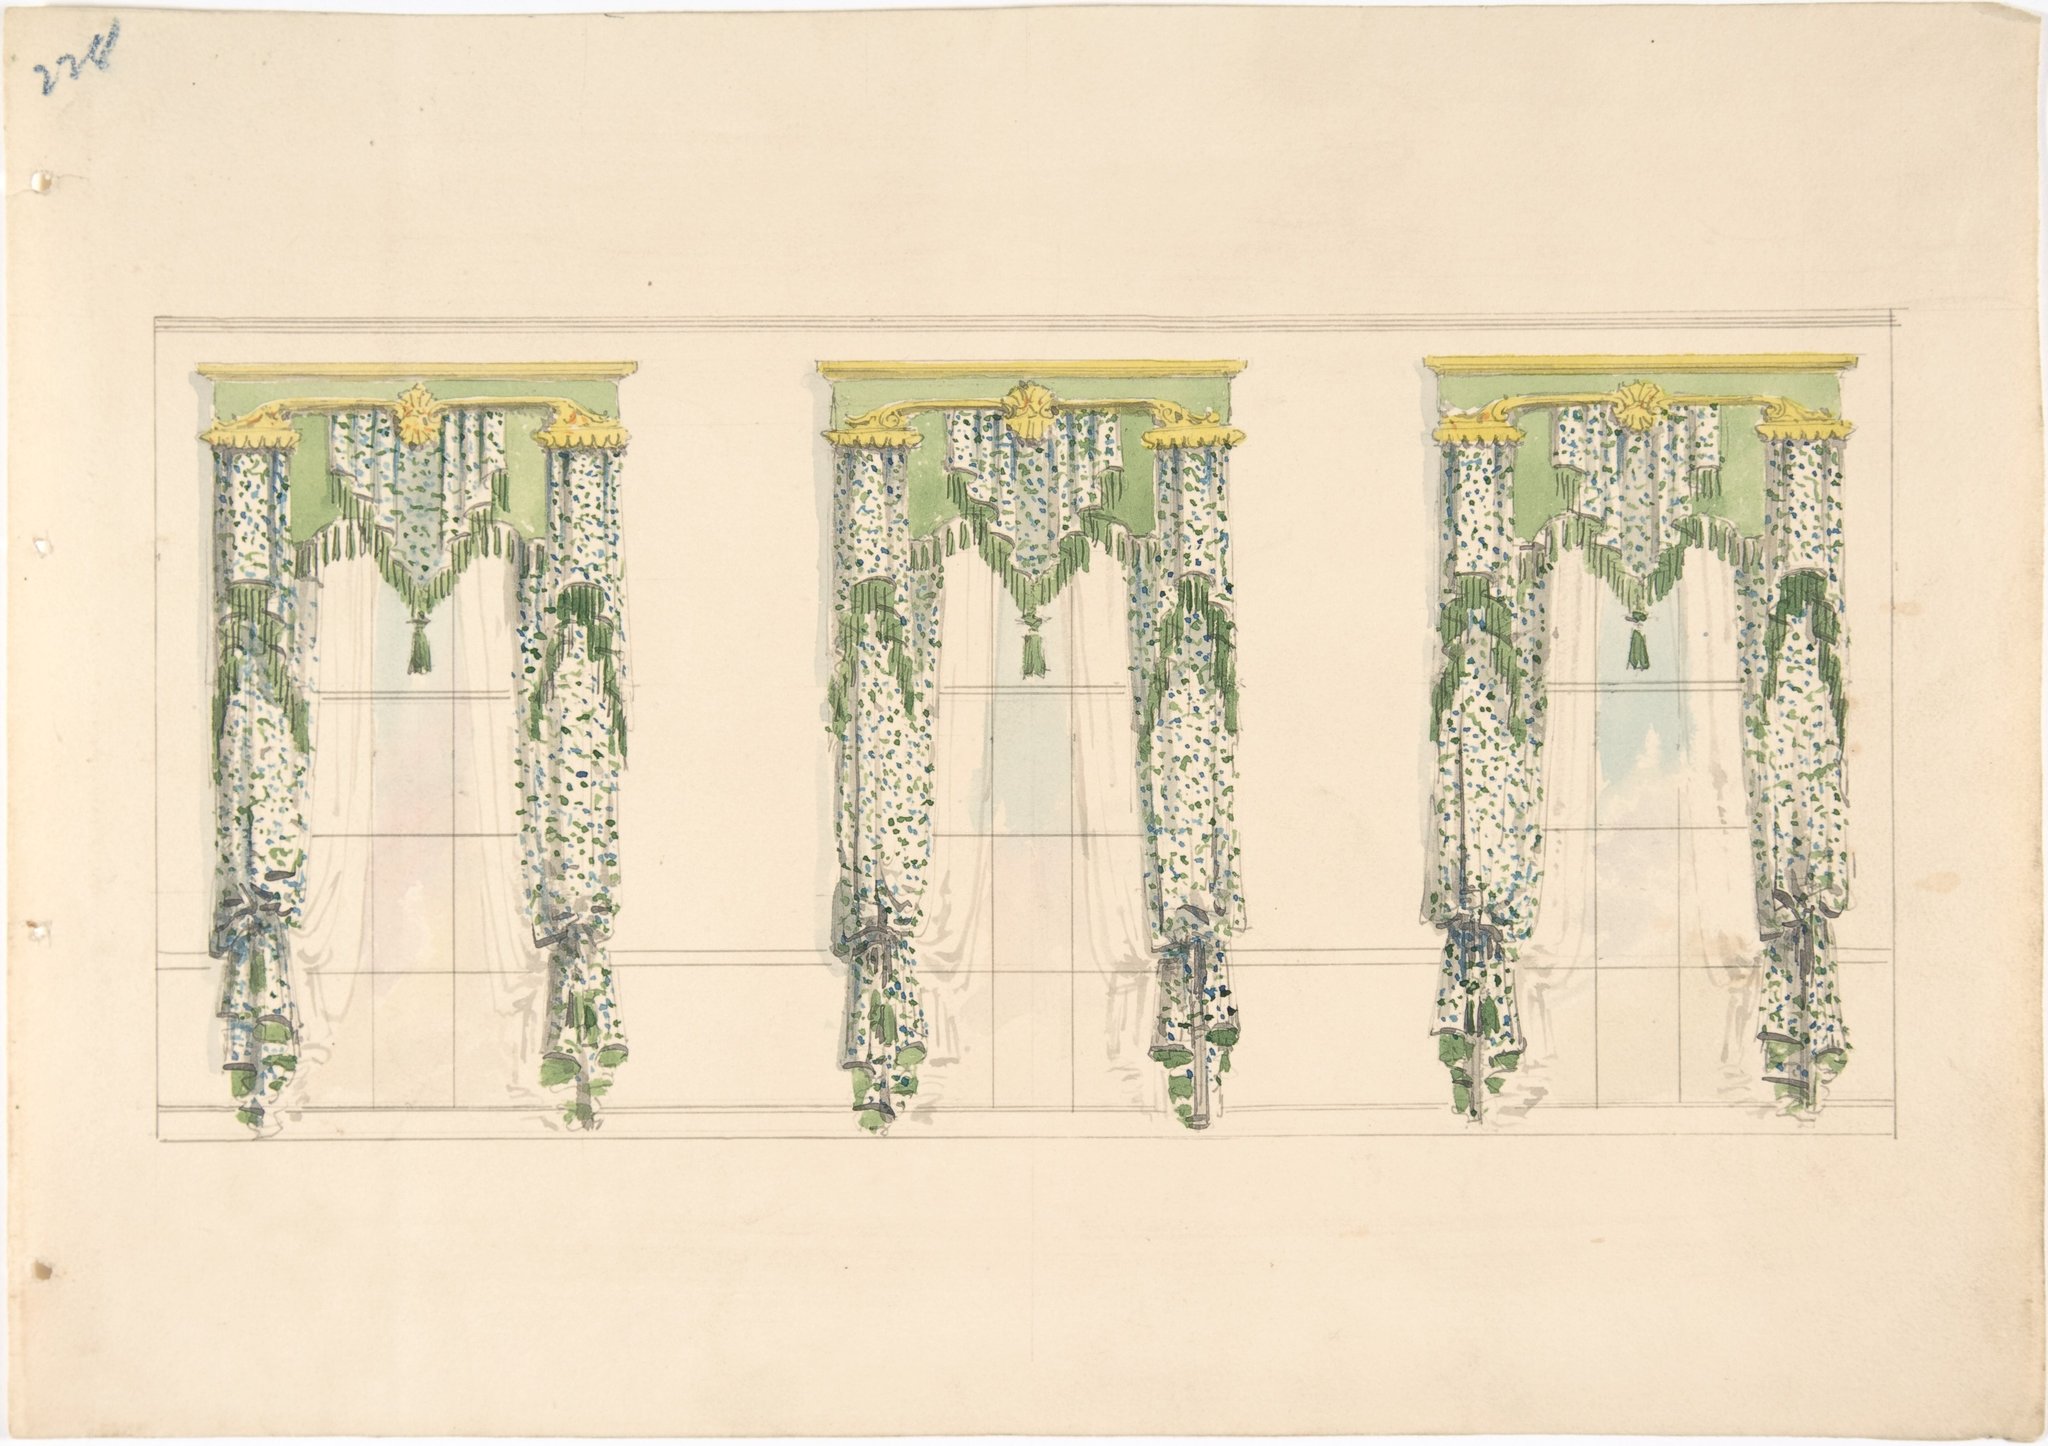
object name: drawing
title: Design for Green and White Curtains with Green Fringes and a Green and Gold Pediment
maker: anonymous, british, 19th century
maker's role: artist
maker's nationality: british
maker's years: 1800-1900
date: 1801-1833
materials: ink, watercolor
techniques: brush, pen, wash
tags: windows,curtains